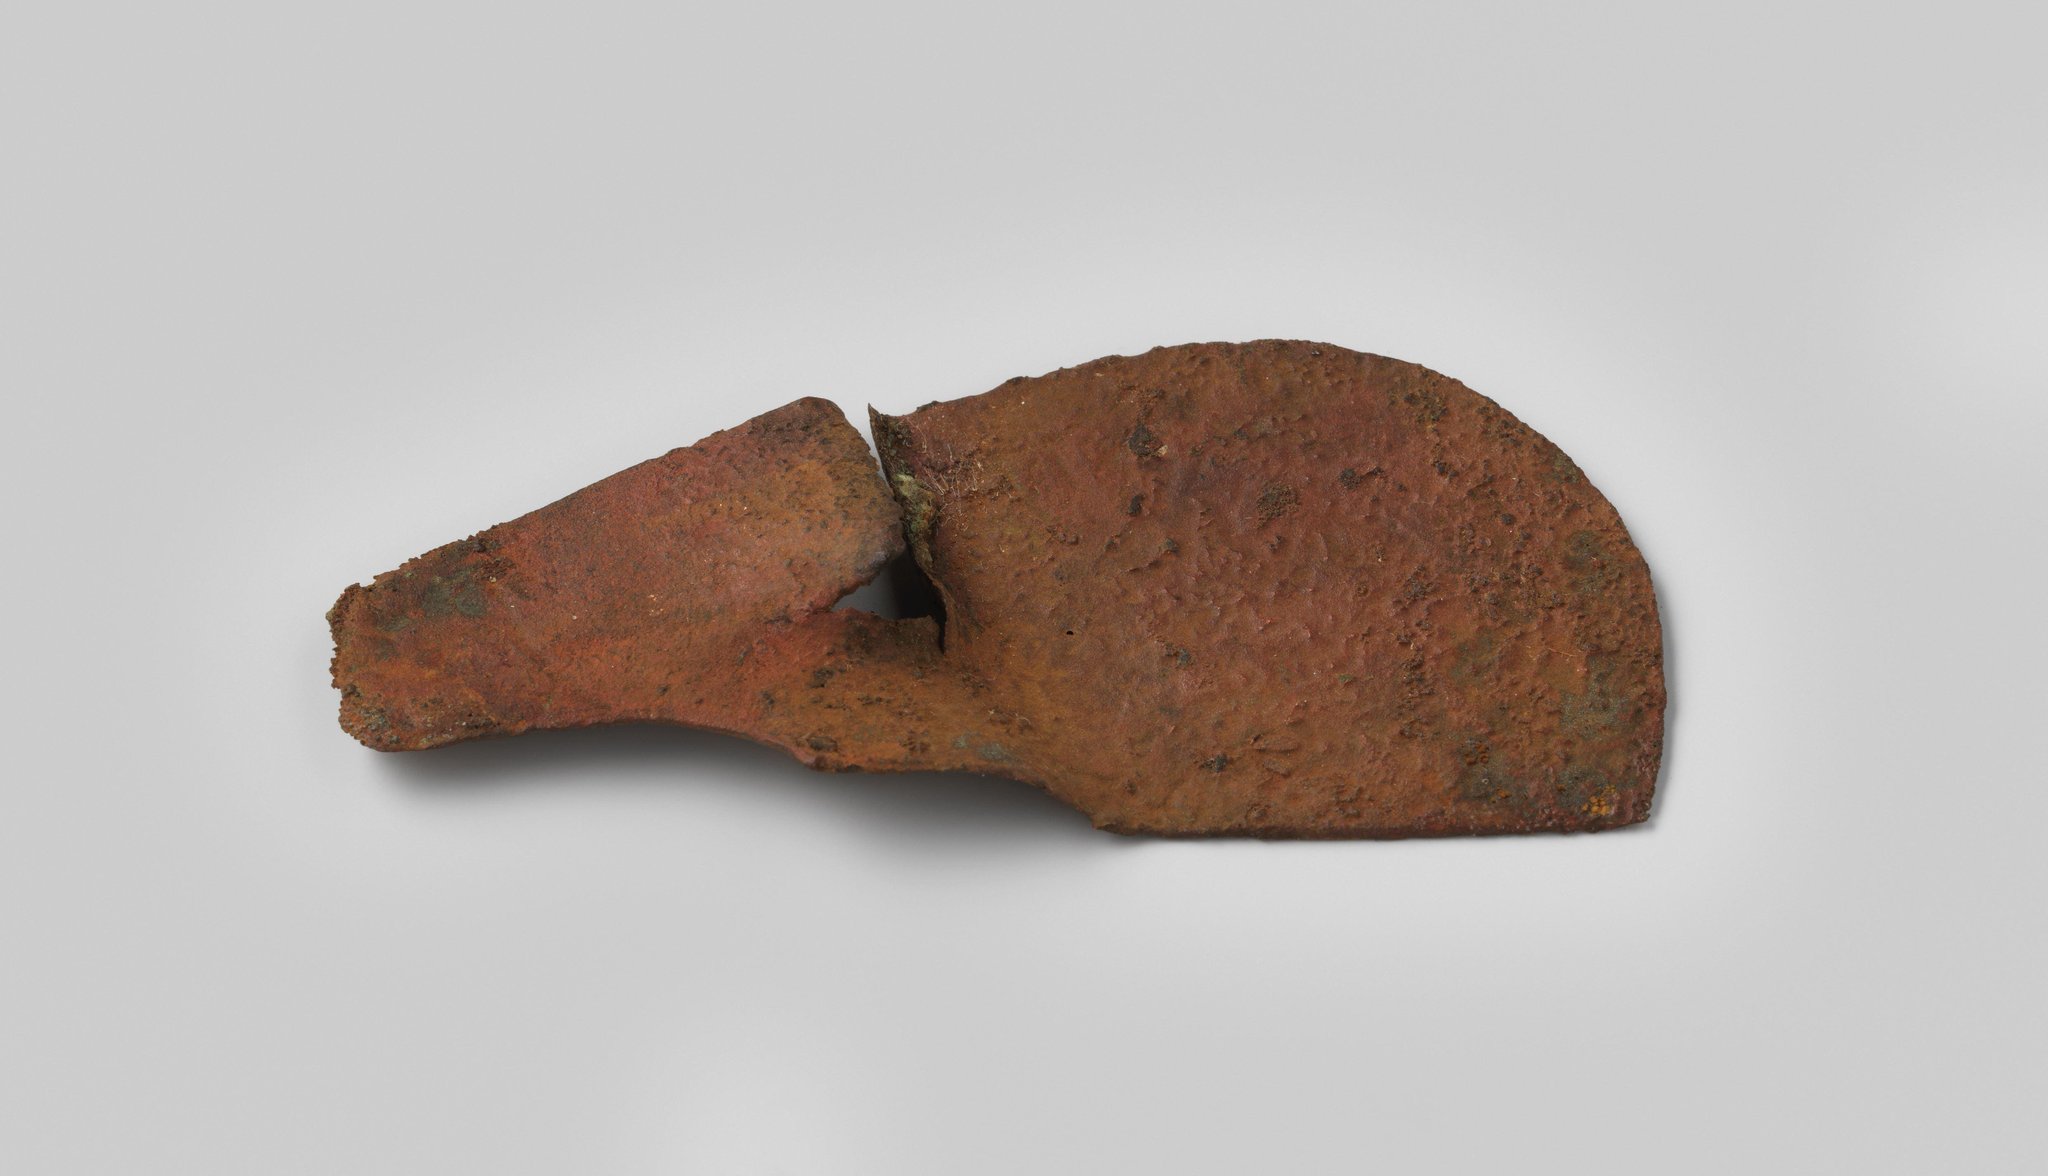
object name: fragment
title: Fragment koperen plaatwerk uit het wrak van de Oost-Indiëvaarder Hollandia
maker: Anonymous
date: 1700-1743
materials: copper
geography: netherlands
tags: verenigde oostindische compagnie, hollandia (schip), annet